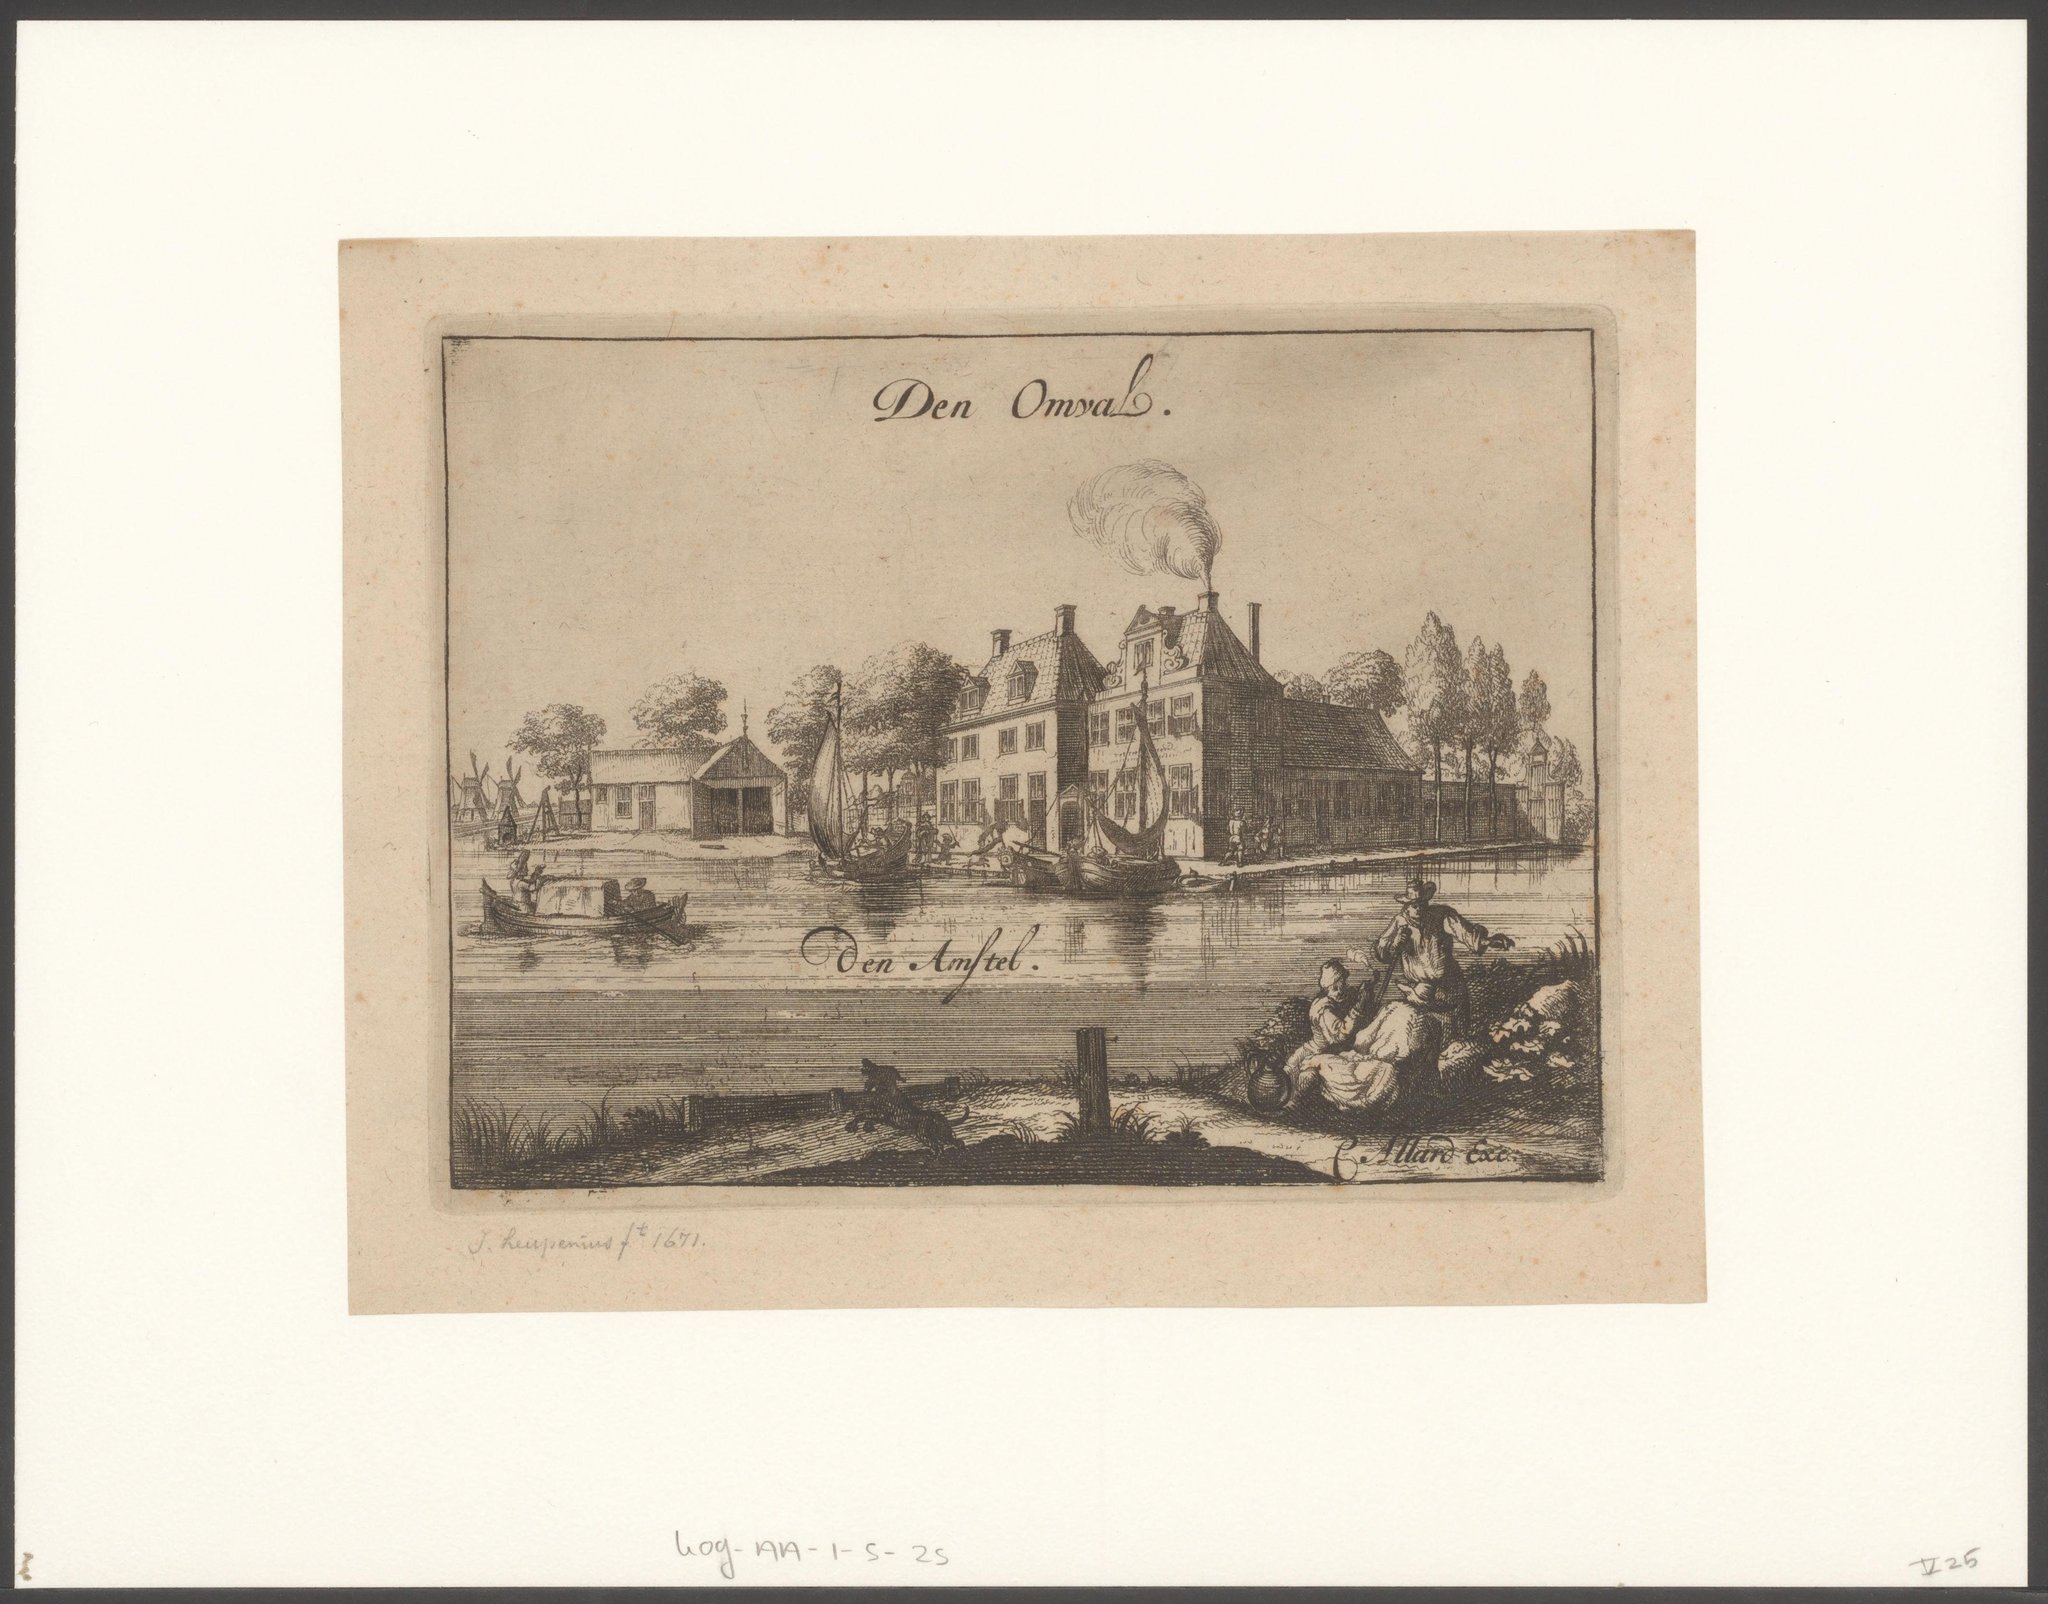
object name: print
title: Gezicht op Huis de Omval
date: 1671-1680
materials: paper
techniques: etching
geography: amsterdam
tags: sailing-ship, sailing-boat, city-view in general; 'veduta', river, rural housing, e.g. country-house, villa, cottage, boat propelled by man or animal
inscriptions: inscription: ‘J. Leupenius: / v.d. Kellen, Cat. de Ridder Nr 582. / non [...]anné per la [...]’, inscription: ‘J. Leupenius ft 1671.’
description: Onderwerpsrubriek binnen de Atlas Amsterdam: Amstel buiten de stad, Amsteldijk.